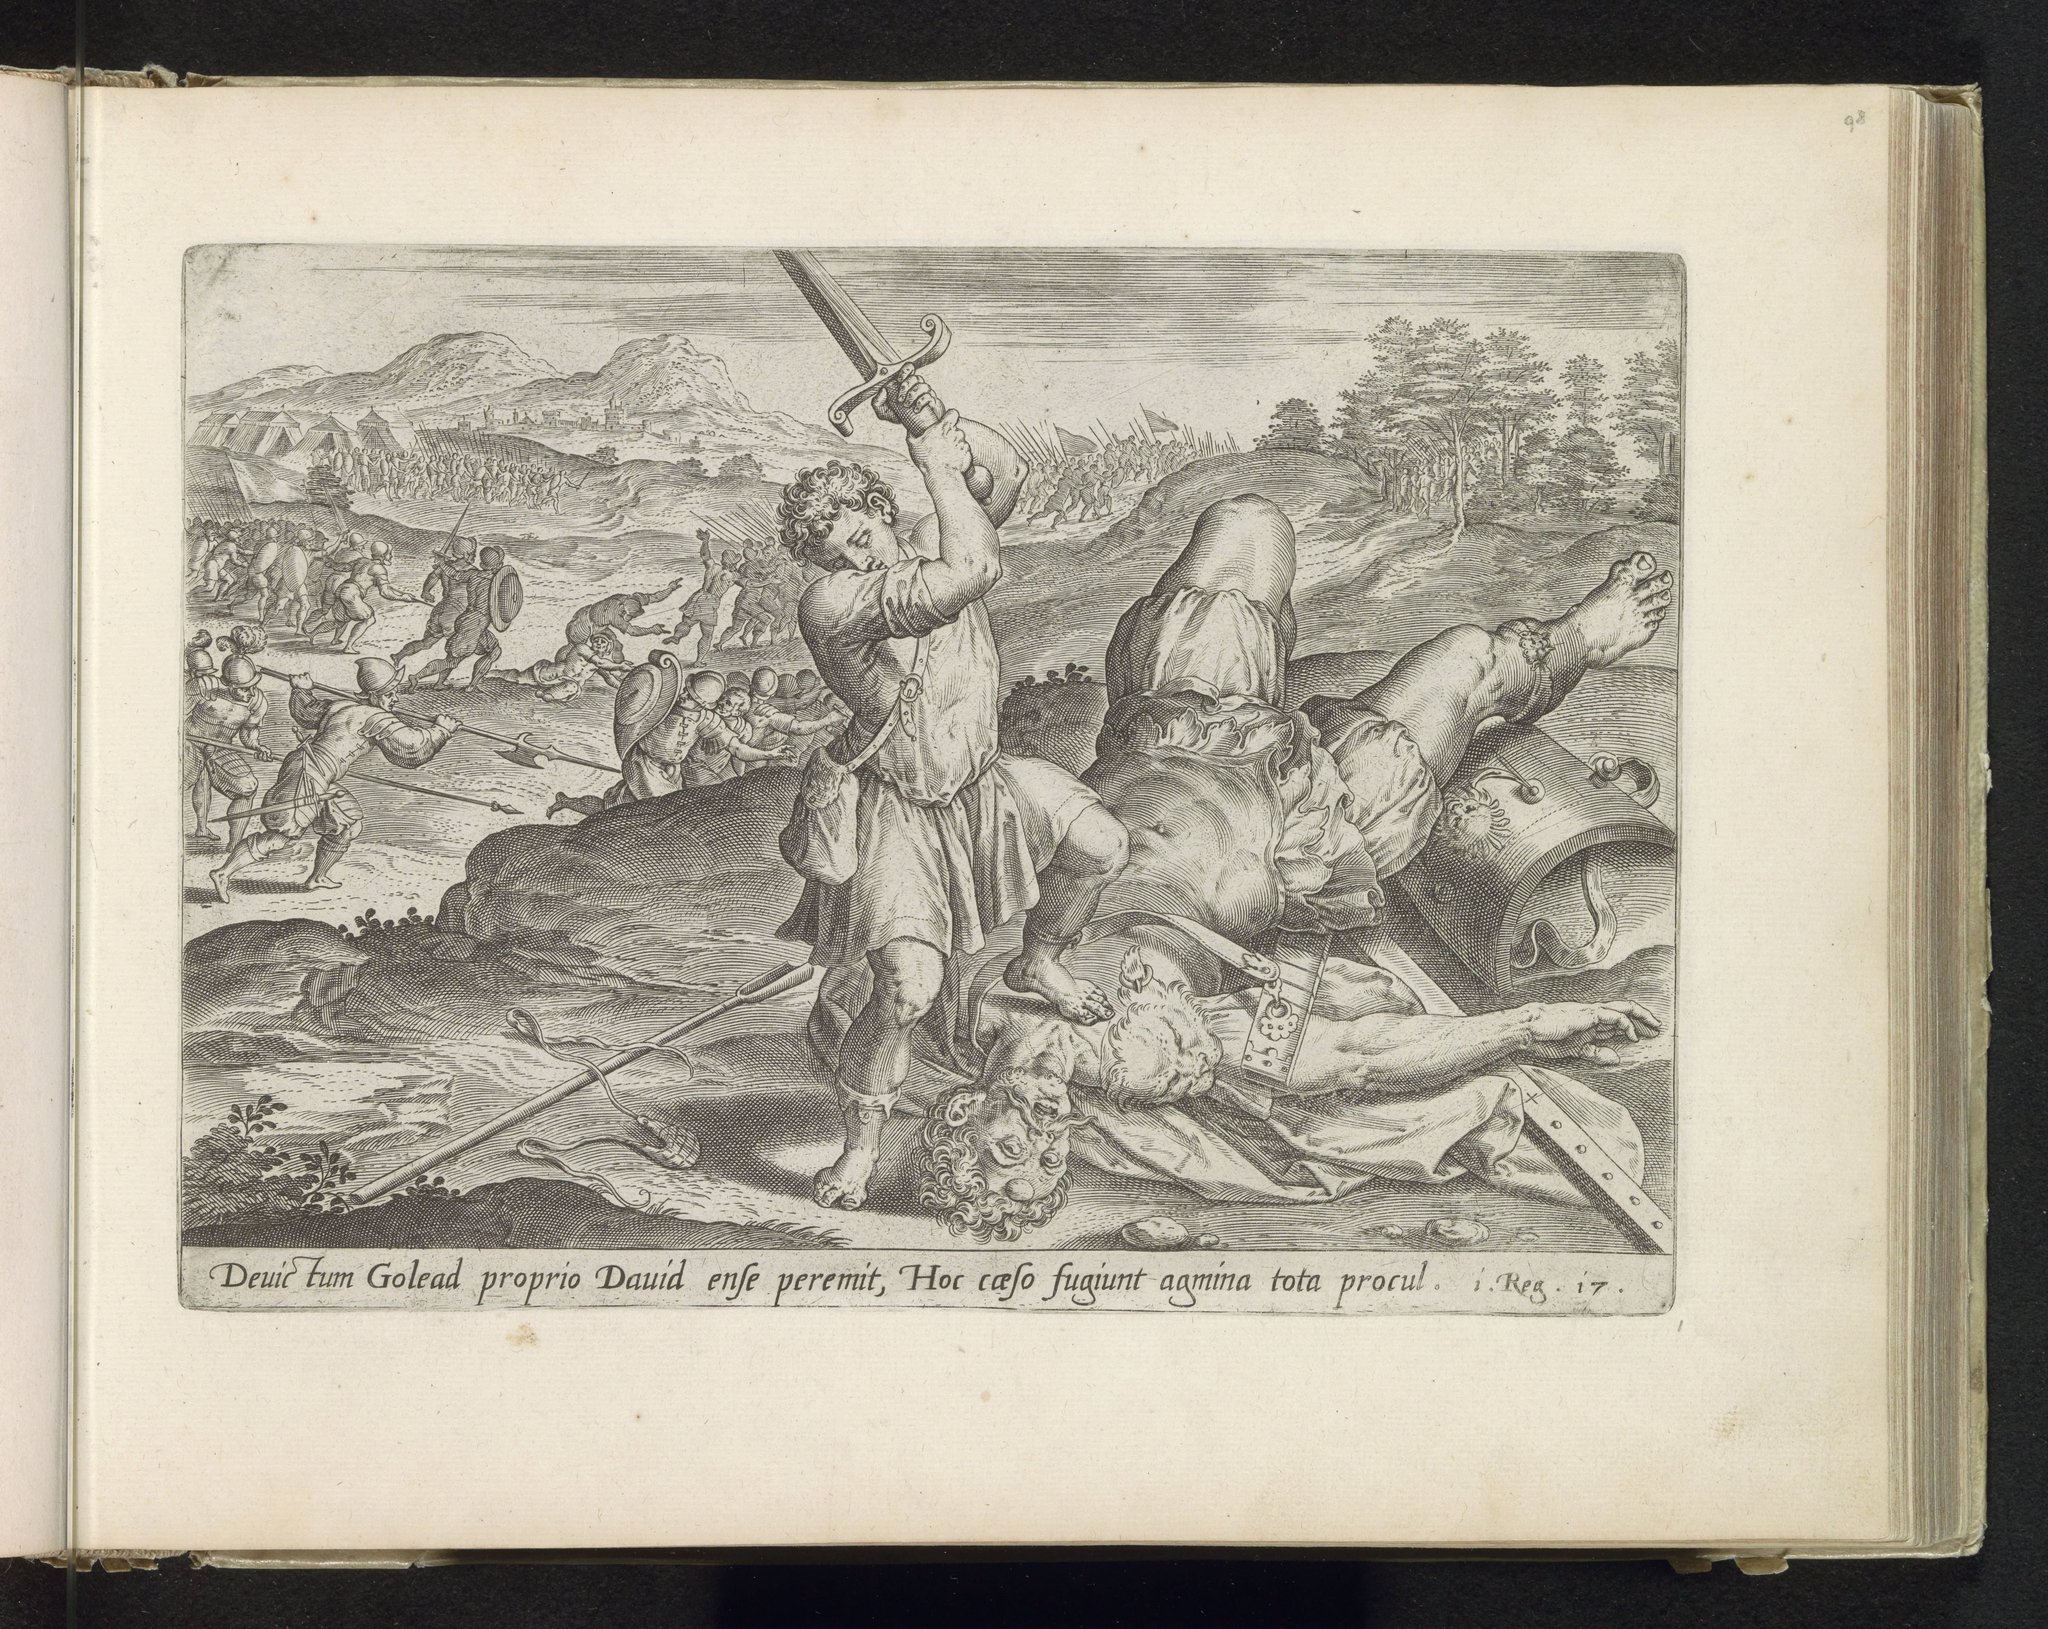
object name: album leaf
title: Thesaurus sacrarum historiaru[m] veteris testame[n]ti, elega[n]tissimis imaginibus expressu[m] excelle[n]tissimoru[m] in hac arte viroru[m] opera: nu[n]c primu[m] in luce[m] editus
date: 1585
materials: paper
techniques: engraving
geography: antwerp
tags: david beheads goliath with a sword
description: Goliat ligt op de grond. David staat met één voet op zijn borst en heft het zwaard van Goliat boven zijn hoofd, klaar om hem te onthoofden. Links vluchten de Filistijnen voor de soldaten van Saul. Onder de voorstelling een verwijzing in het Latijn naar de Bijbeltekst in 1 Sam. 17. Deze prent maakt deel uit van een album.